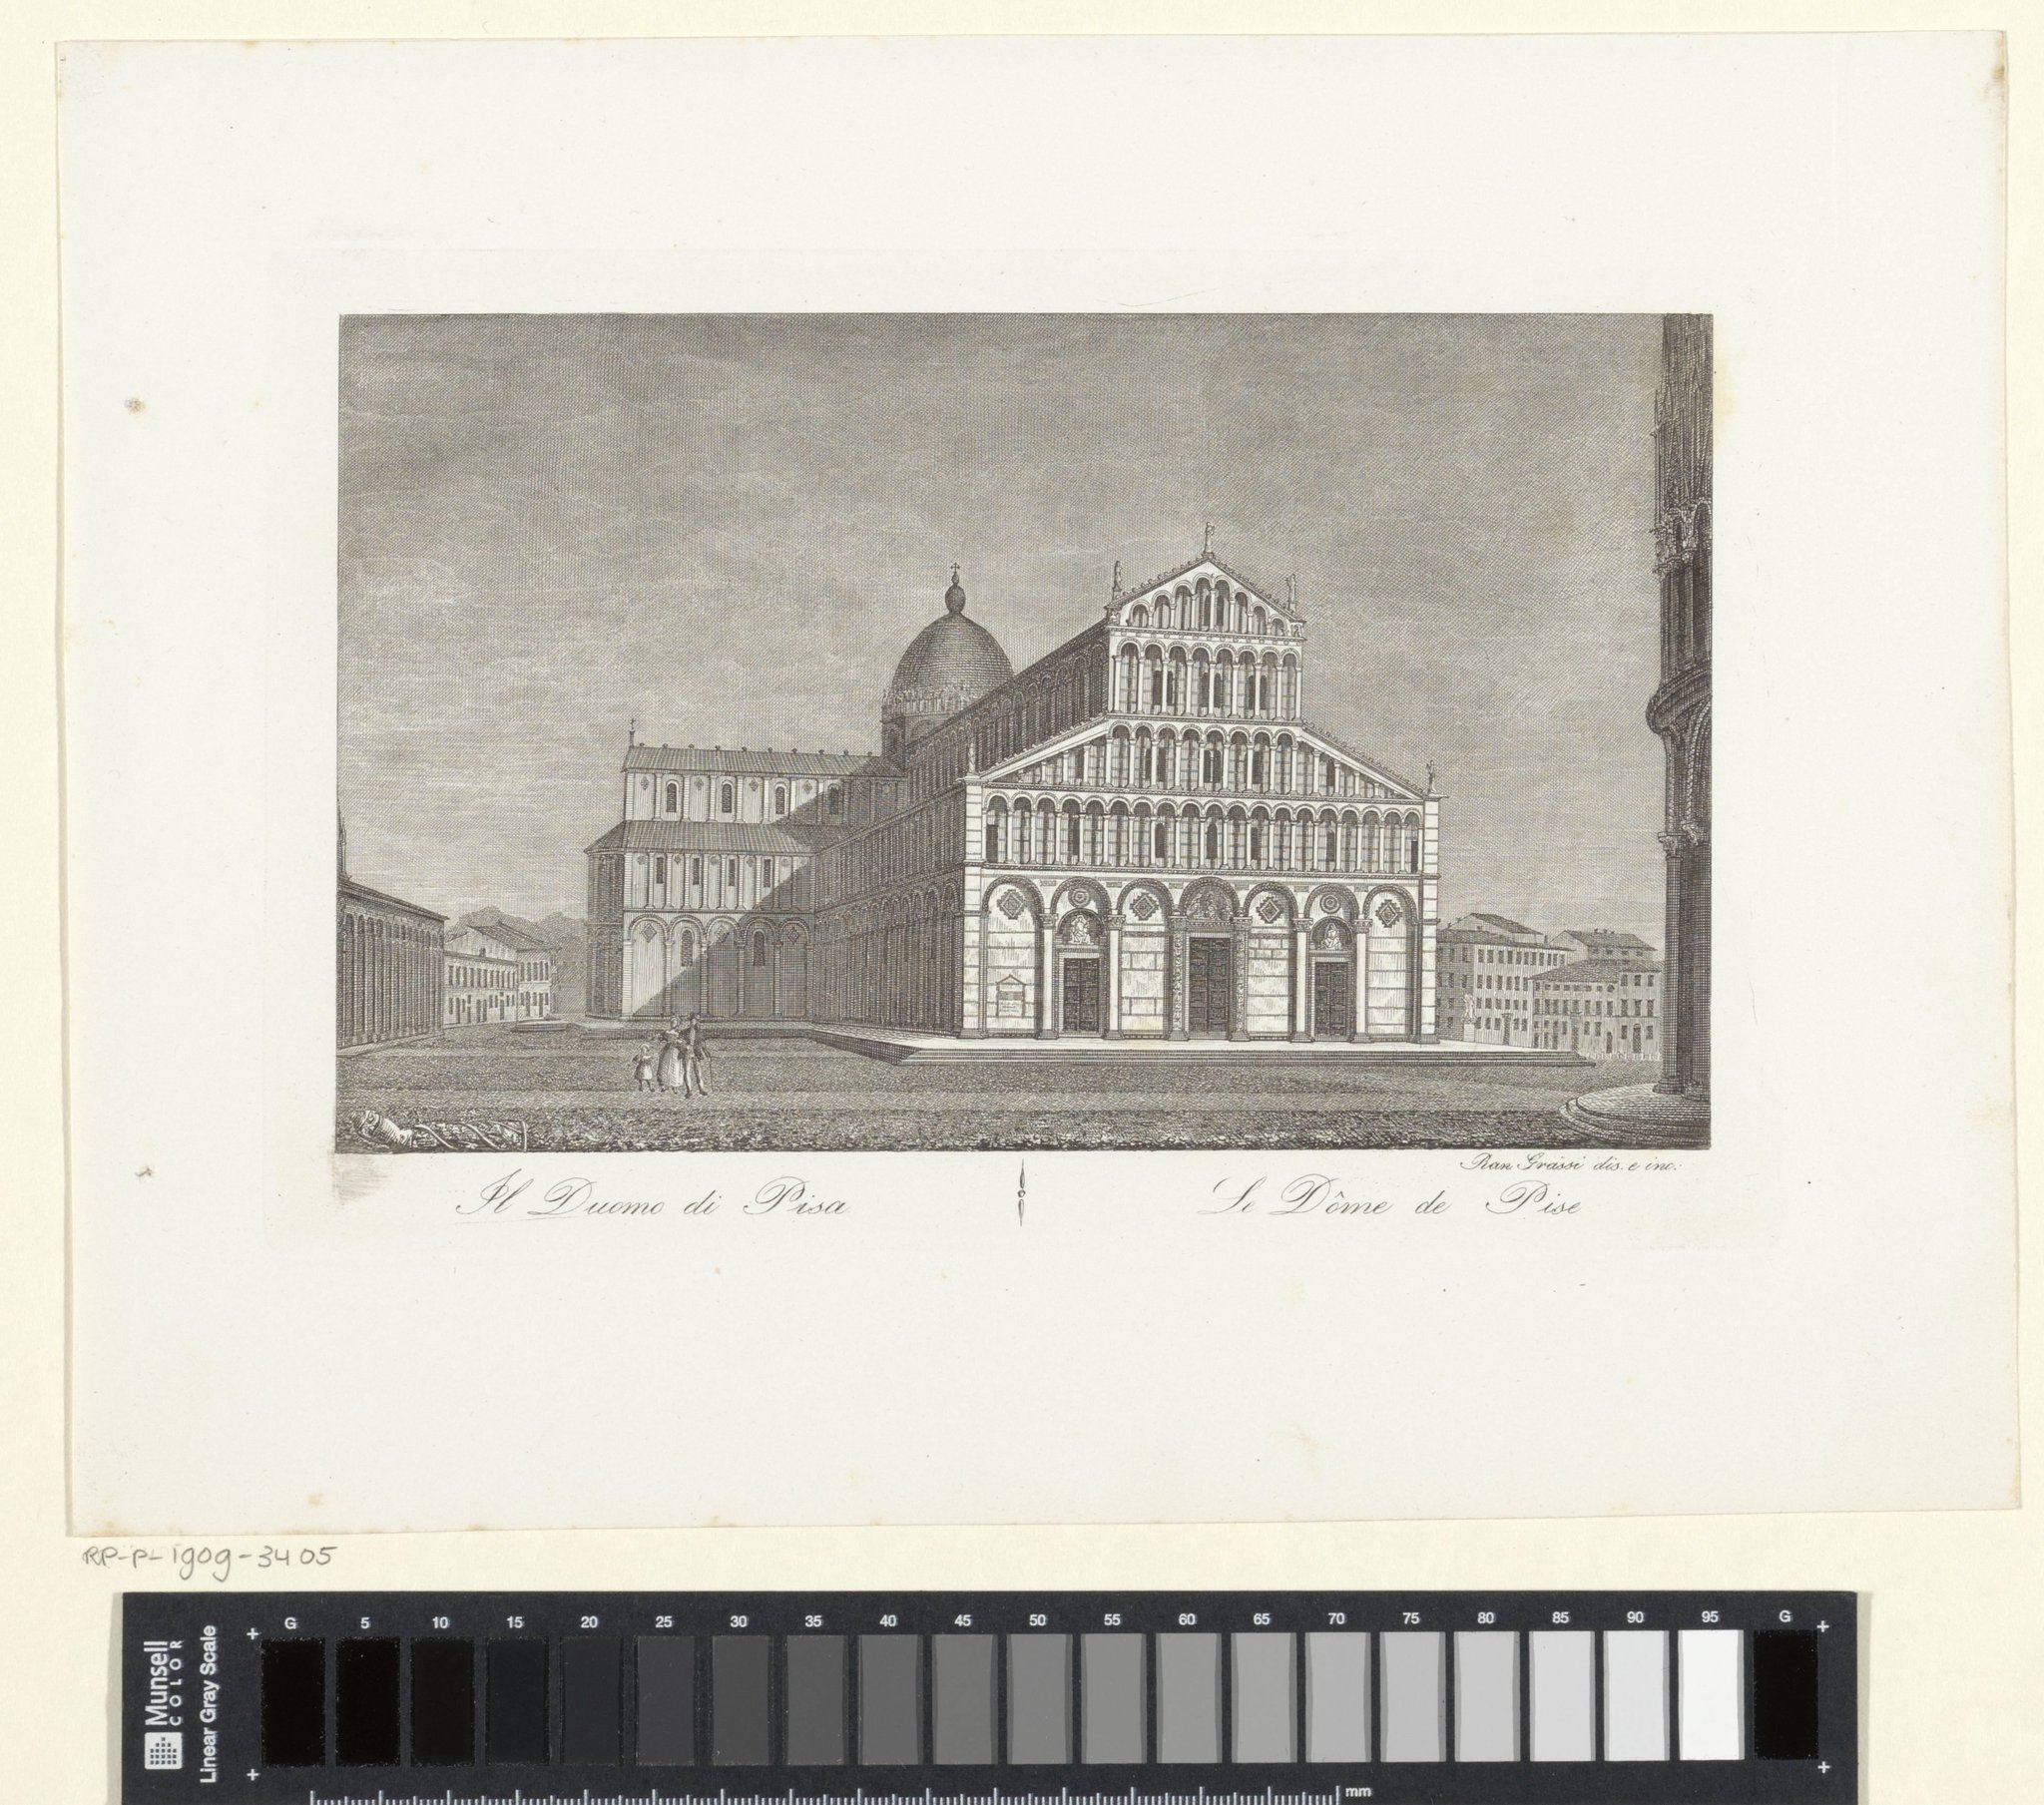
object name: print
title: Voorstellingen van de meeste prominente gebouwen in Pisa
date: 1854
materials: paper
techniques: etching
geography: pisa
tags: city-view in general; 'veduta'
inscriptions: collector's mark: Lugt 2228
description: Prent 2 uit een reeks van 8 prenten met omslag.